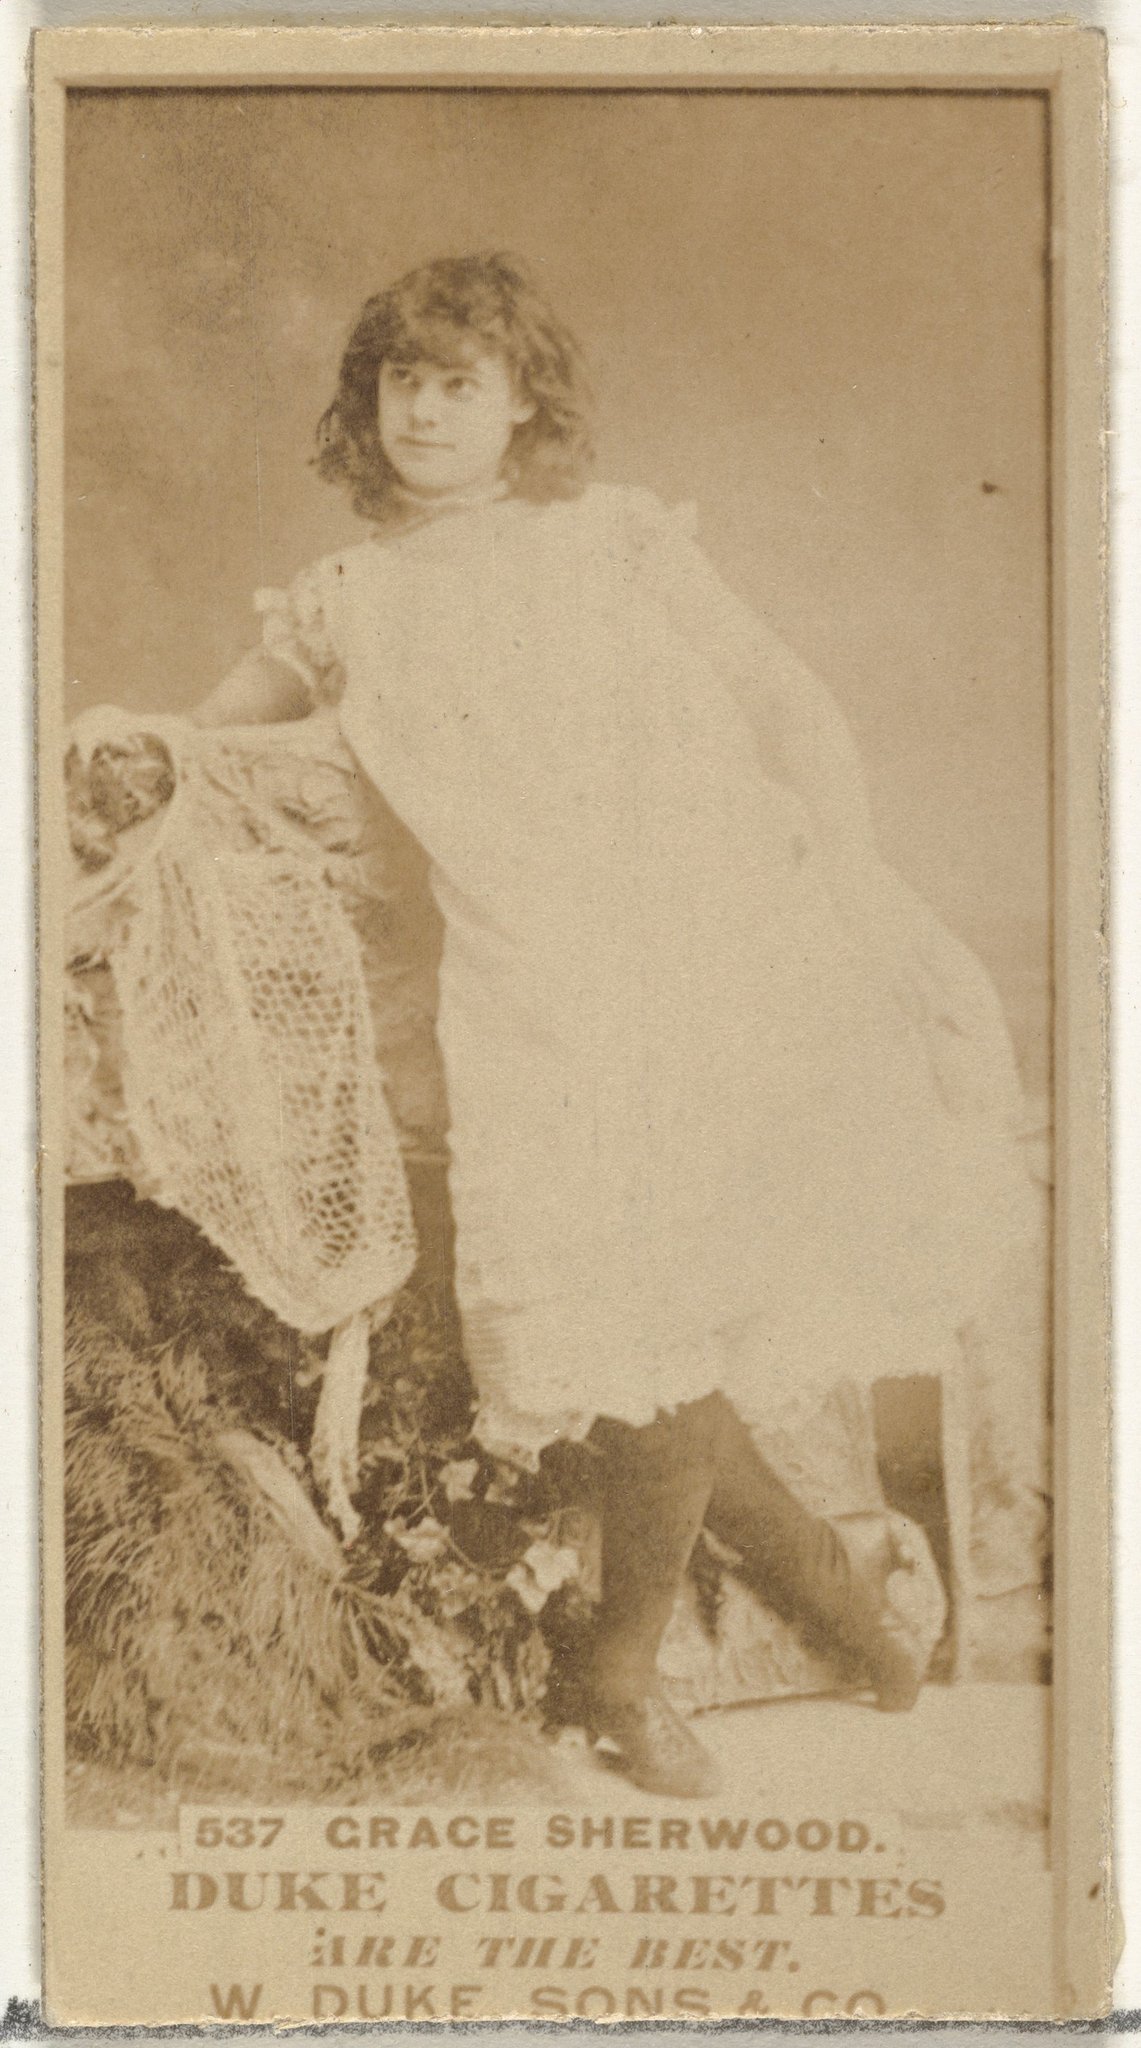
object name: photograph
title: Card Number 537, Grace Sherwood, from the Actors and Actresses series (N145-7) issued by Duke Sons & Co. to promote Duke Cigarettes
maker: w. duke, sons & co.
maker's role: publisher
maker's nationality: american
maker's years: 1870-1920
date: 1880-1889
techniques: albumen silver print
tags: portraits,women,actresses